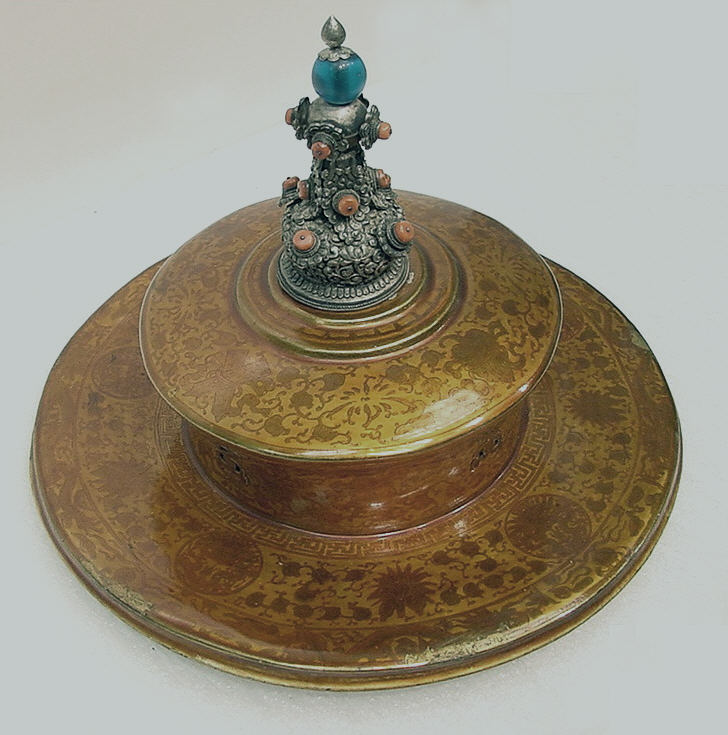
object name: monk's hat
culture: tibetan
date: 1701-1800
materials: coral, glass, lacquer, silver